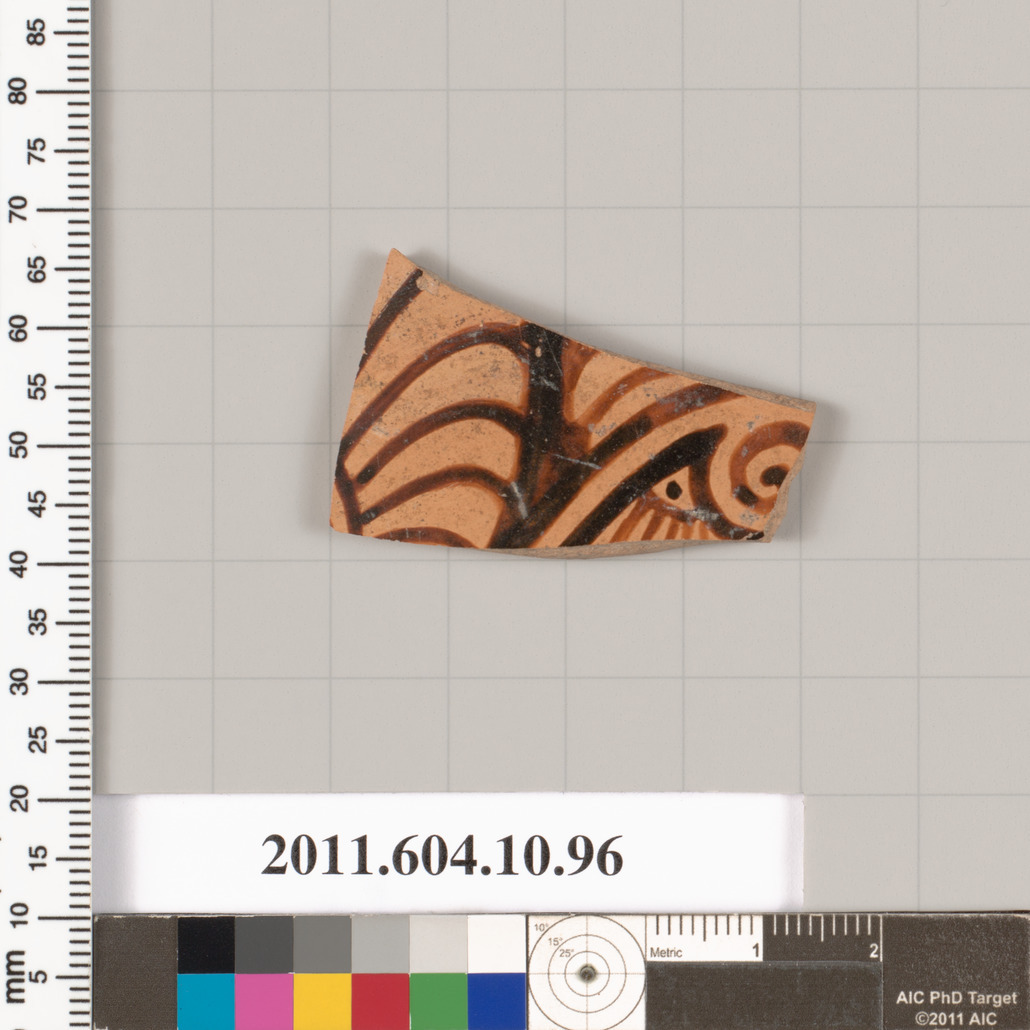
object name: undetermined closed shape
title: Terracotta fragment of a closed shape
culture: etruscan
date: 400-301 BCE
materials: terracotta